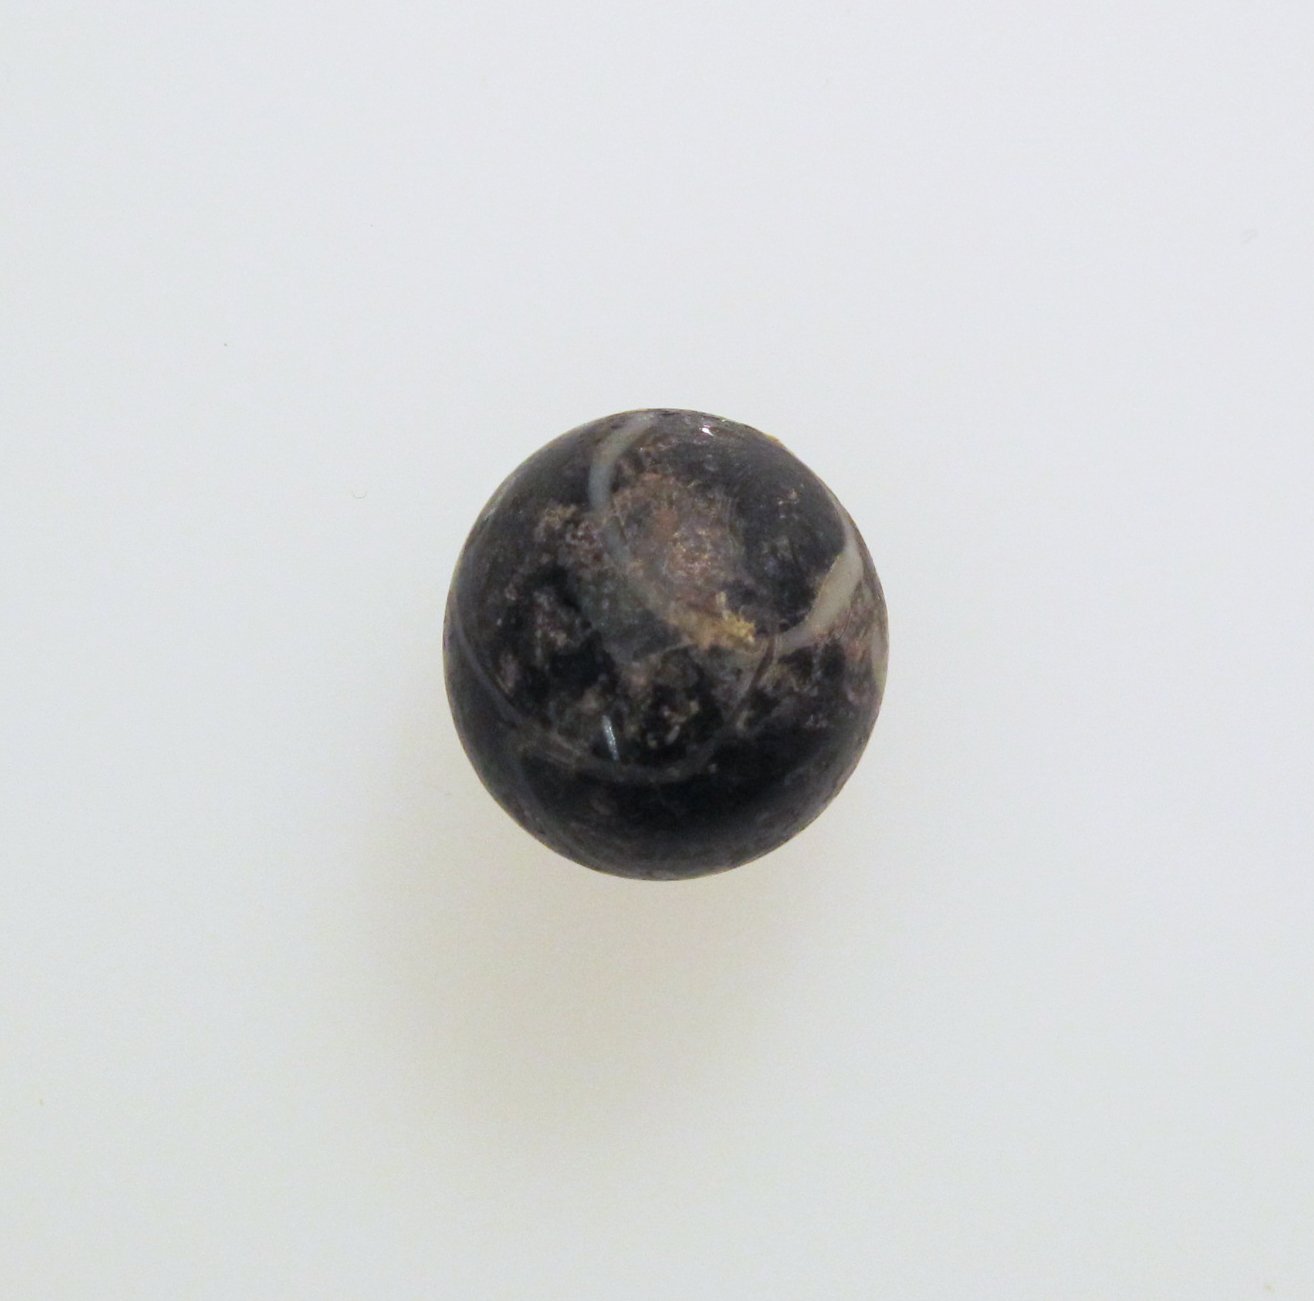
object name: pinhead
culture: roman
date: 100 BCE-500 CE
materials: glass